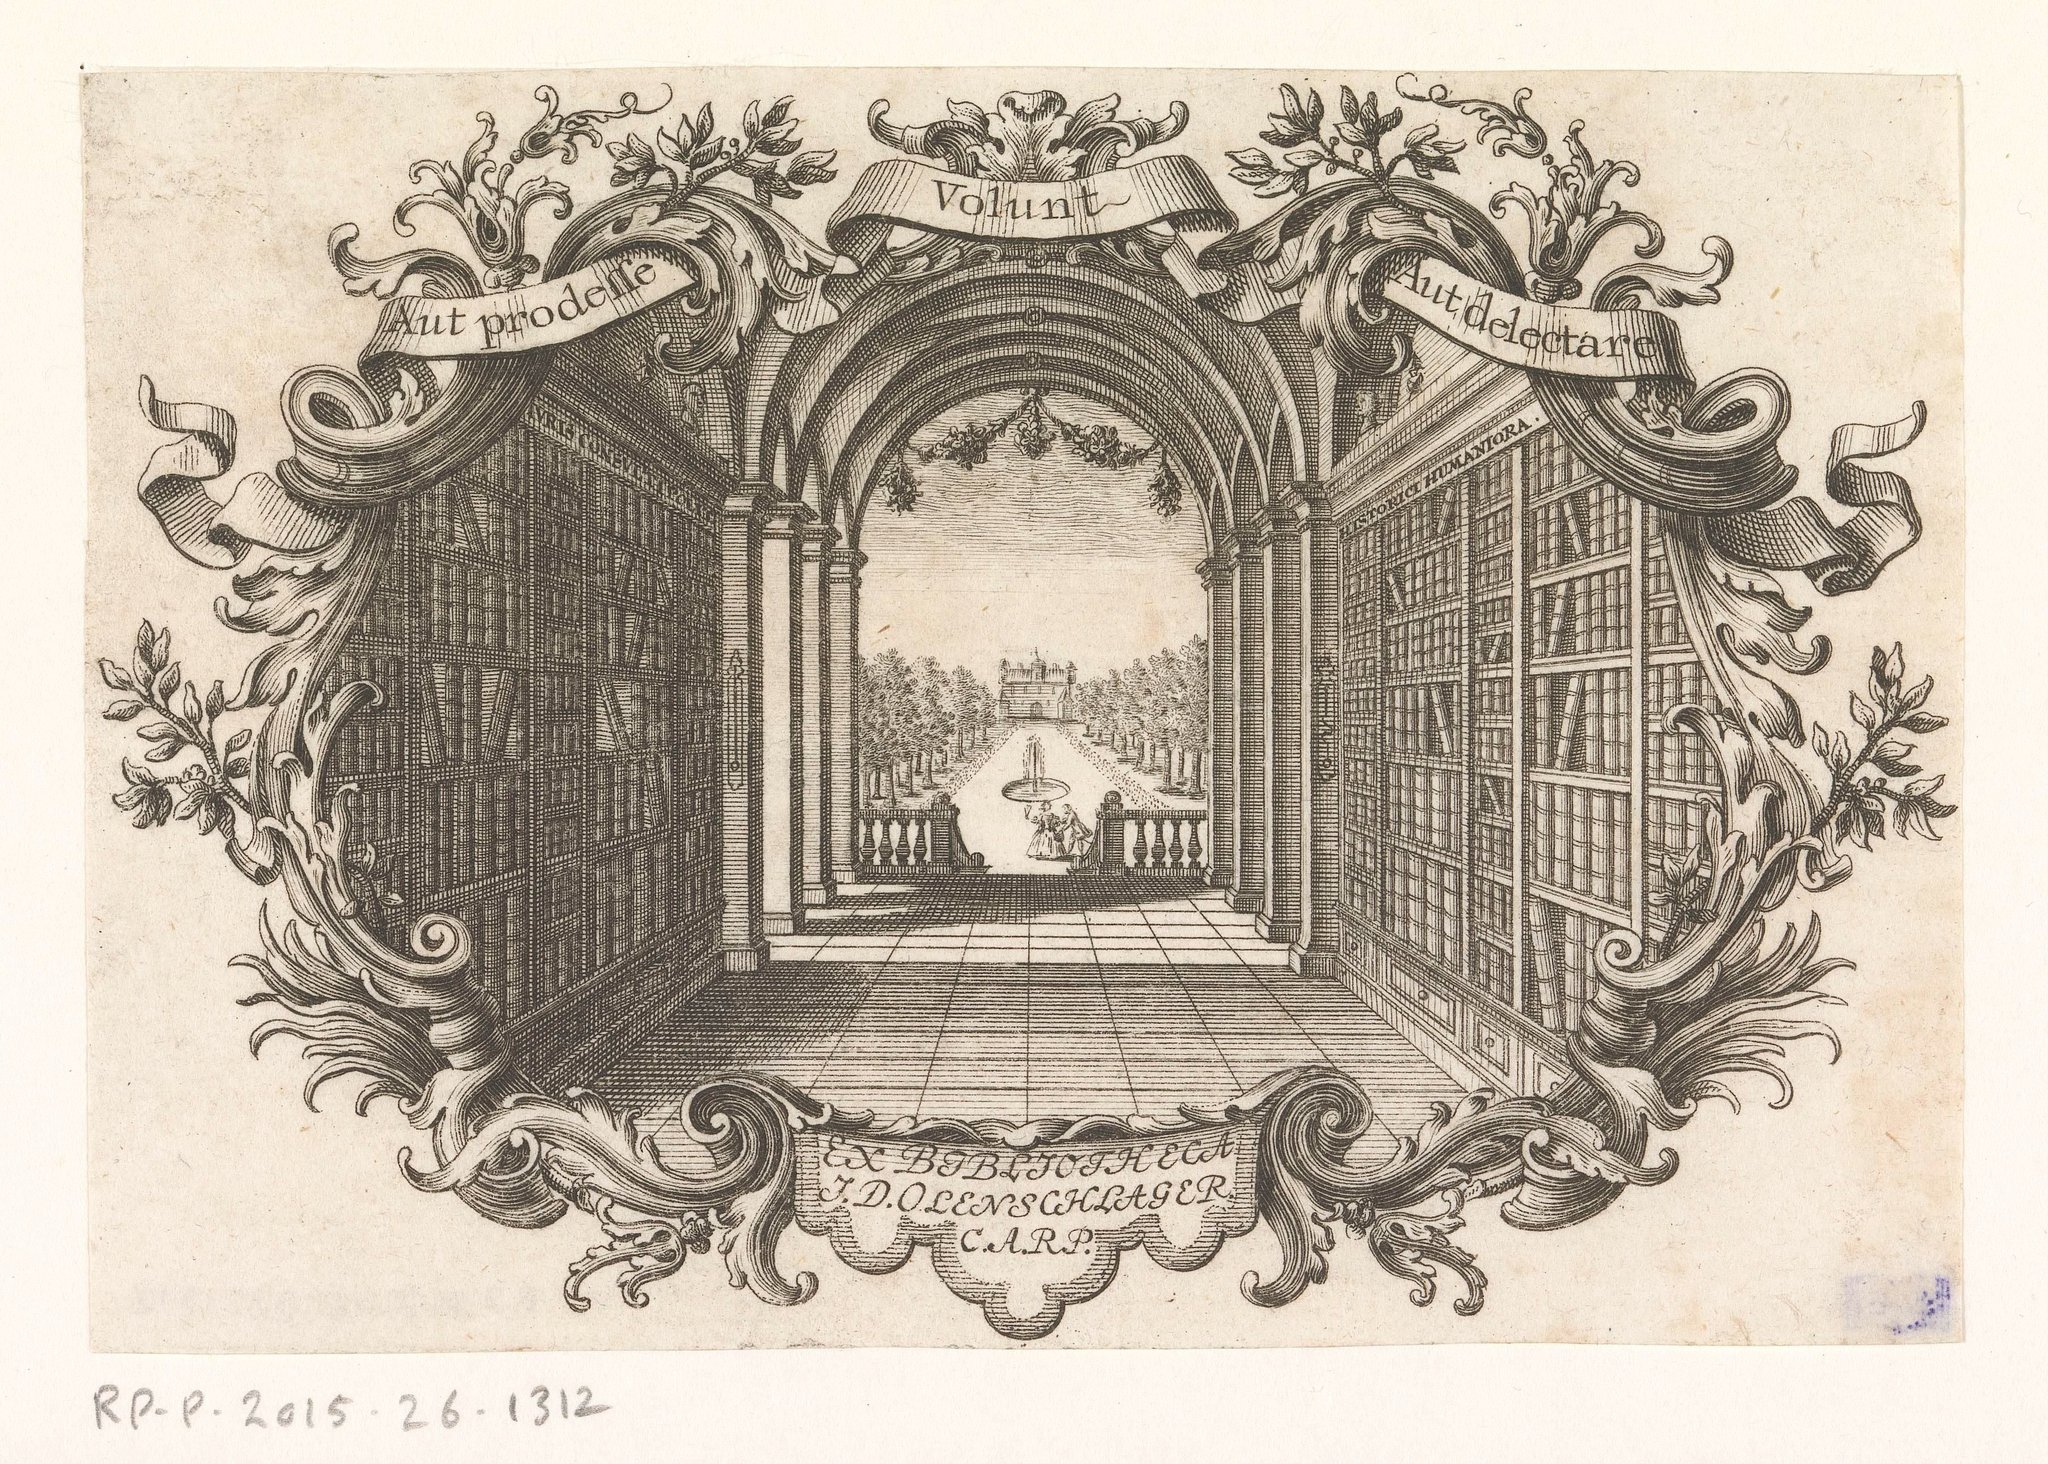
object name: bookplate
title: Ex Bibliotheca J.D. Olenschlager C.A.R.P.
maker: Anonymous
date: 1737-1778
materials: paper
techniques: engraving, etching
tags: bookshelves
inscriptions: collector's mark: Lugt 4780, collector's mark: Lugt 2228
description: Galerij met aan beide kanten boekenkasten. Aan het einde een doorkijk naar een tuin met een fontein. In een omlijsting met het motto: 'Aut prodesse volunt aut delectare'.